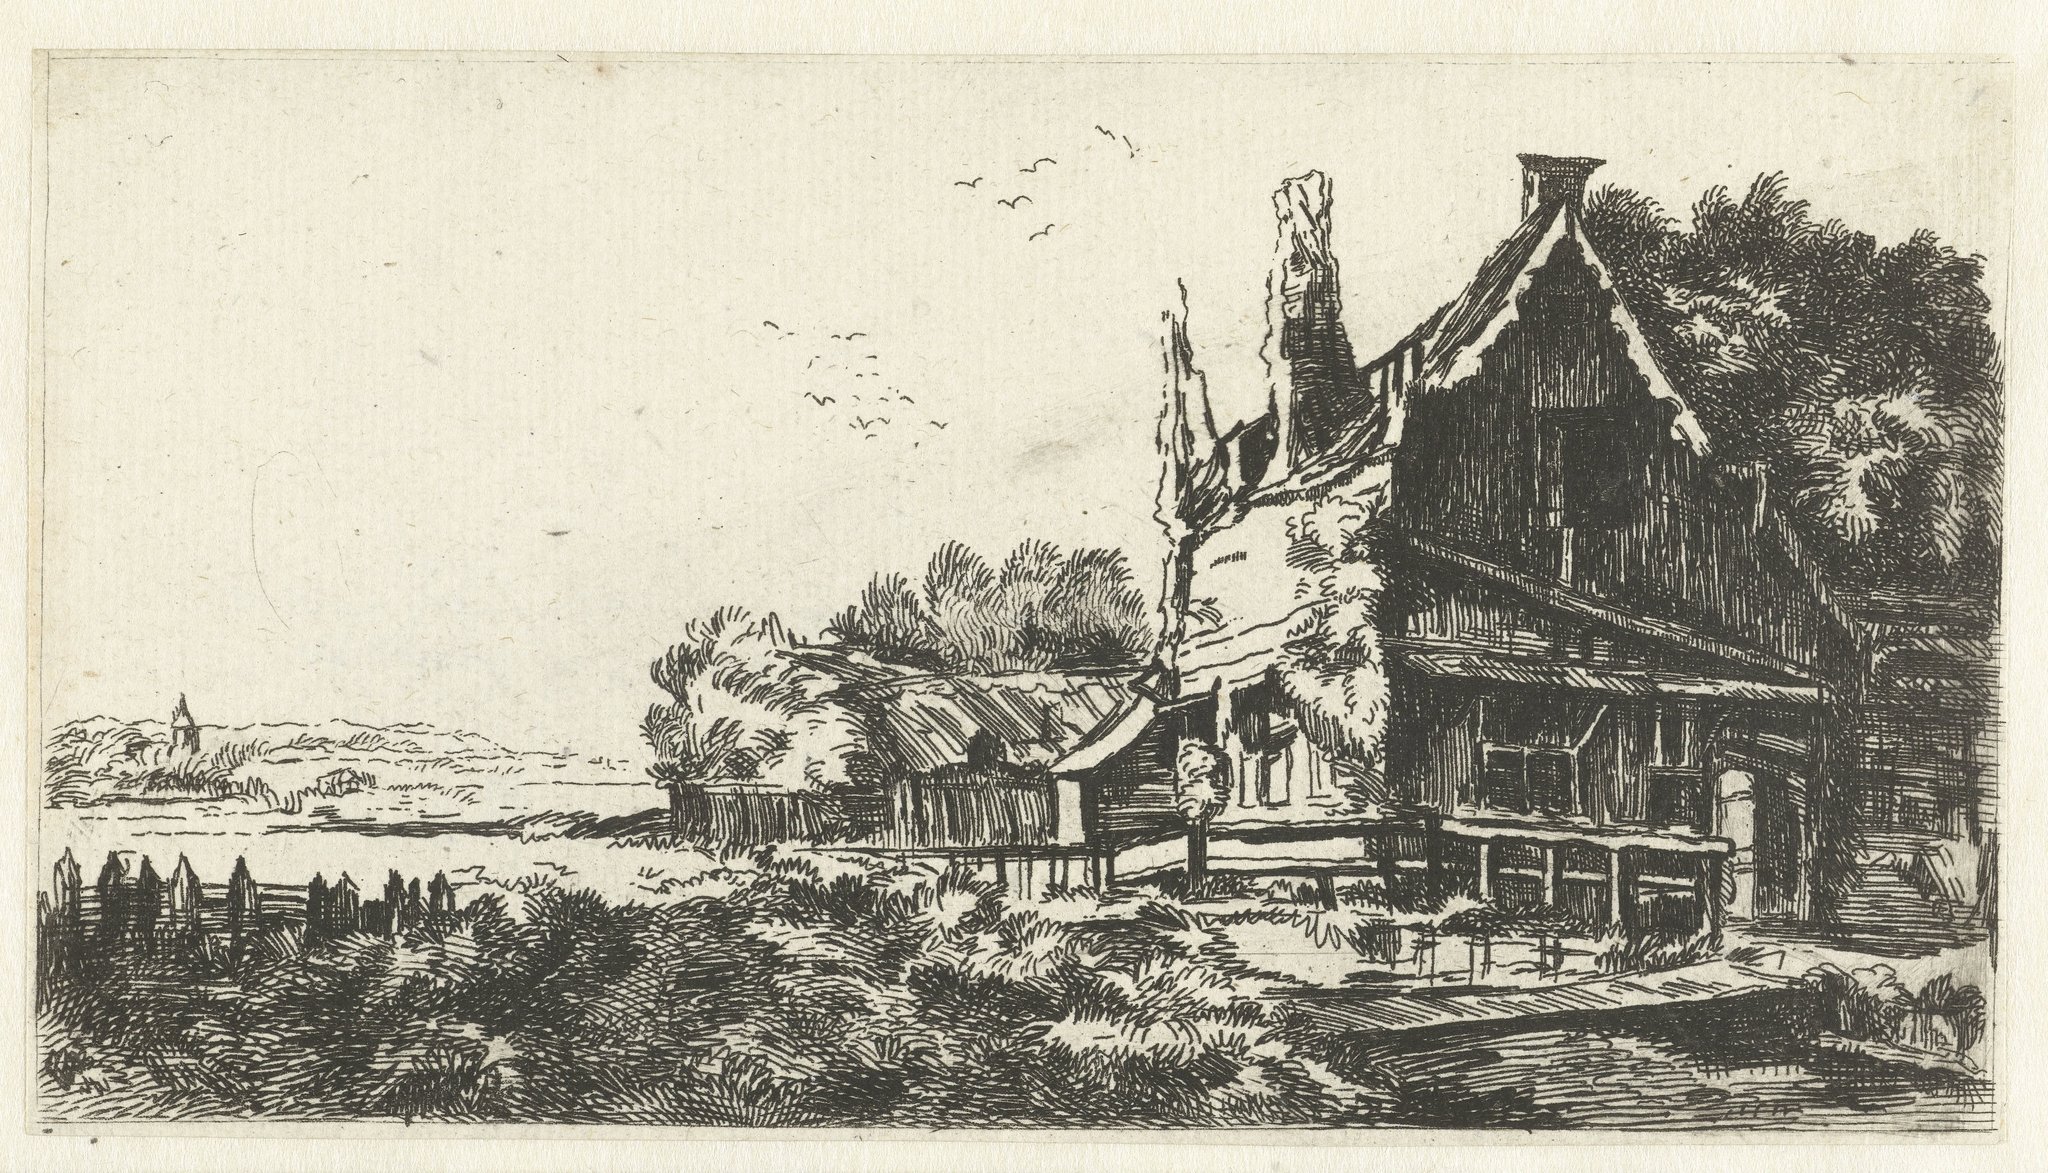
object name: print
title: Huis met drie schoorstenen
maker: pierre françois basan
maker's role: print maker, publisher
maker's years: 1723-1797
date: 1733-1797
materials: paper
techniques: etching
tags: landscapes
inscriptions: collector's mark: Lugt 240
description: Prent voor het eerst gebruikt in: Recueil de Quatre-Vingt-Cinq estampes originales, têtes, paysages et différens sujets, dessinées et gravées par Rembrandt. Parijs: Henry Louis Basan, 1819.